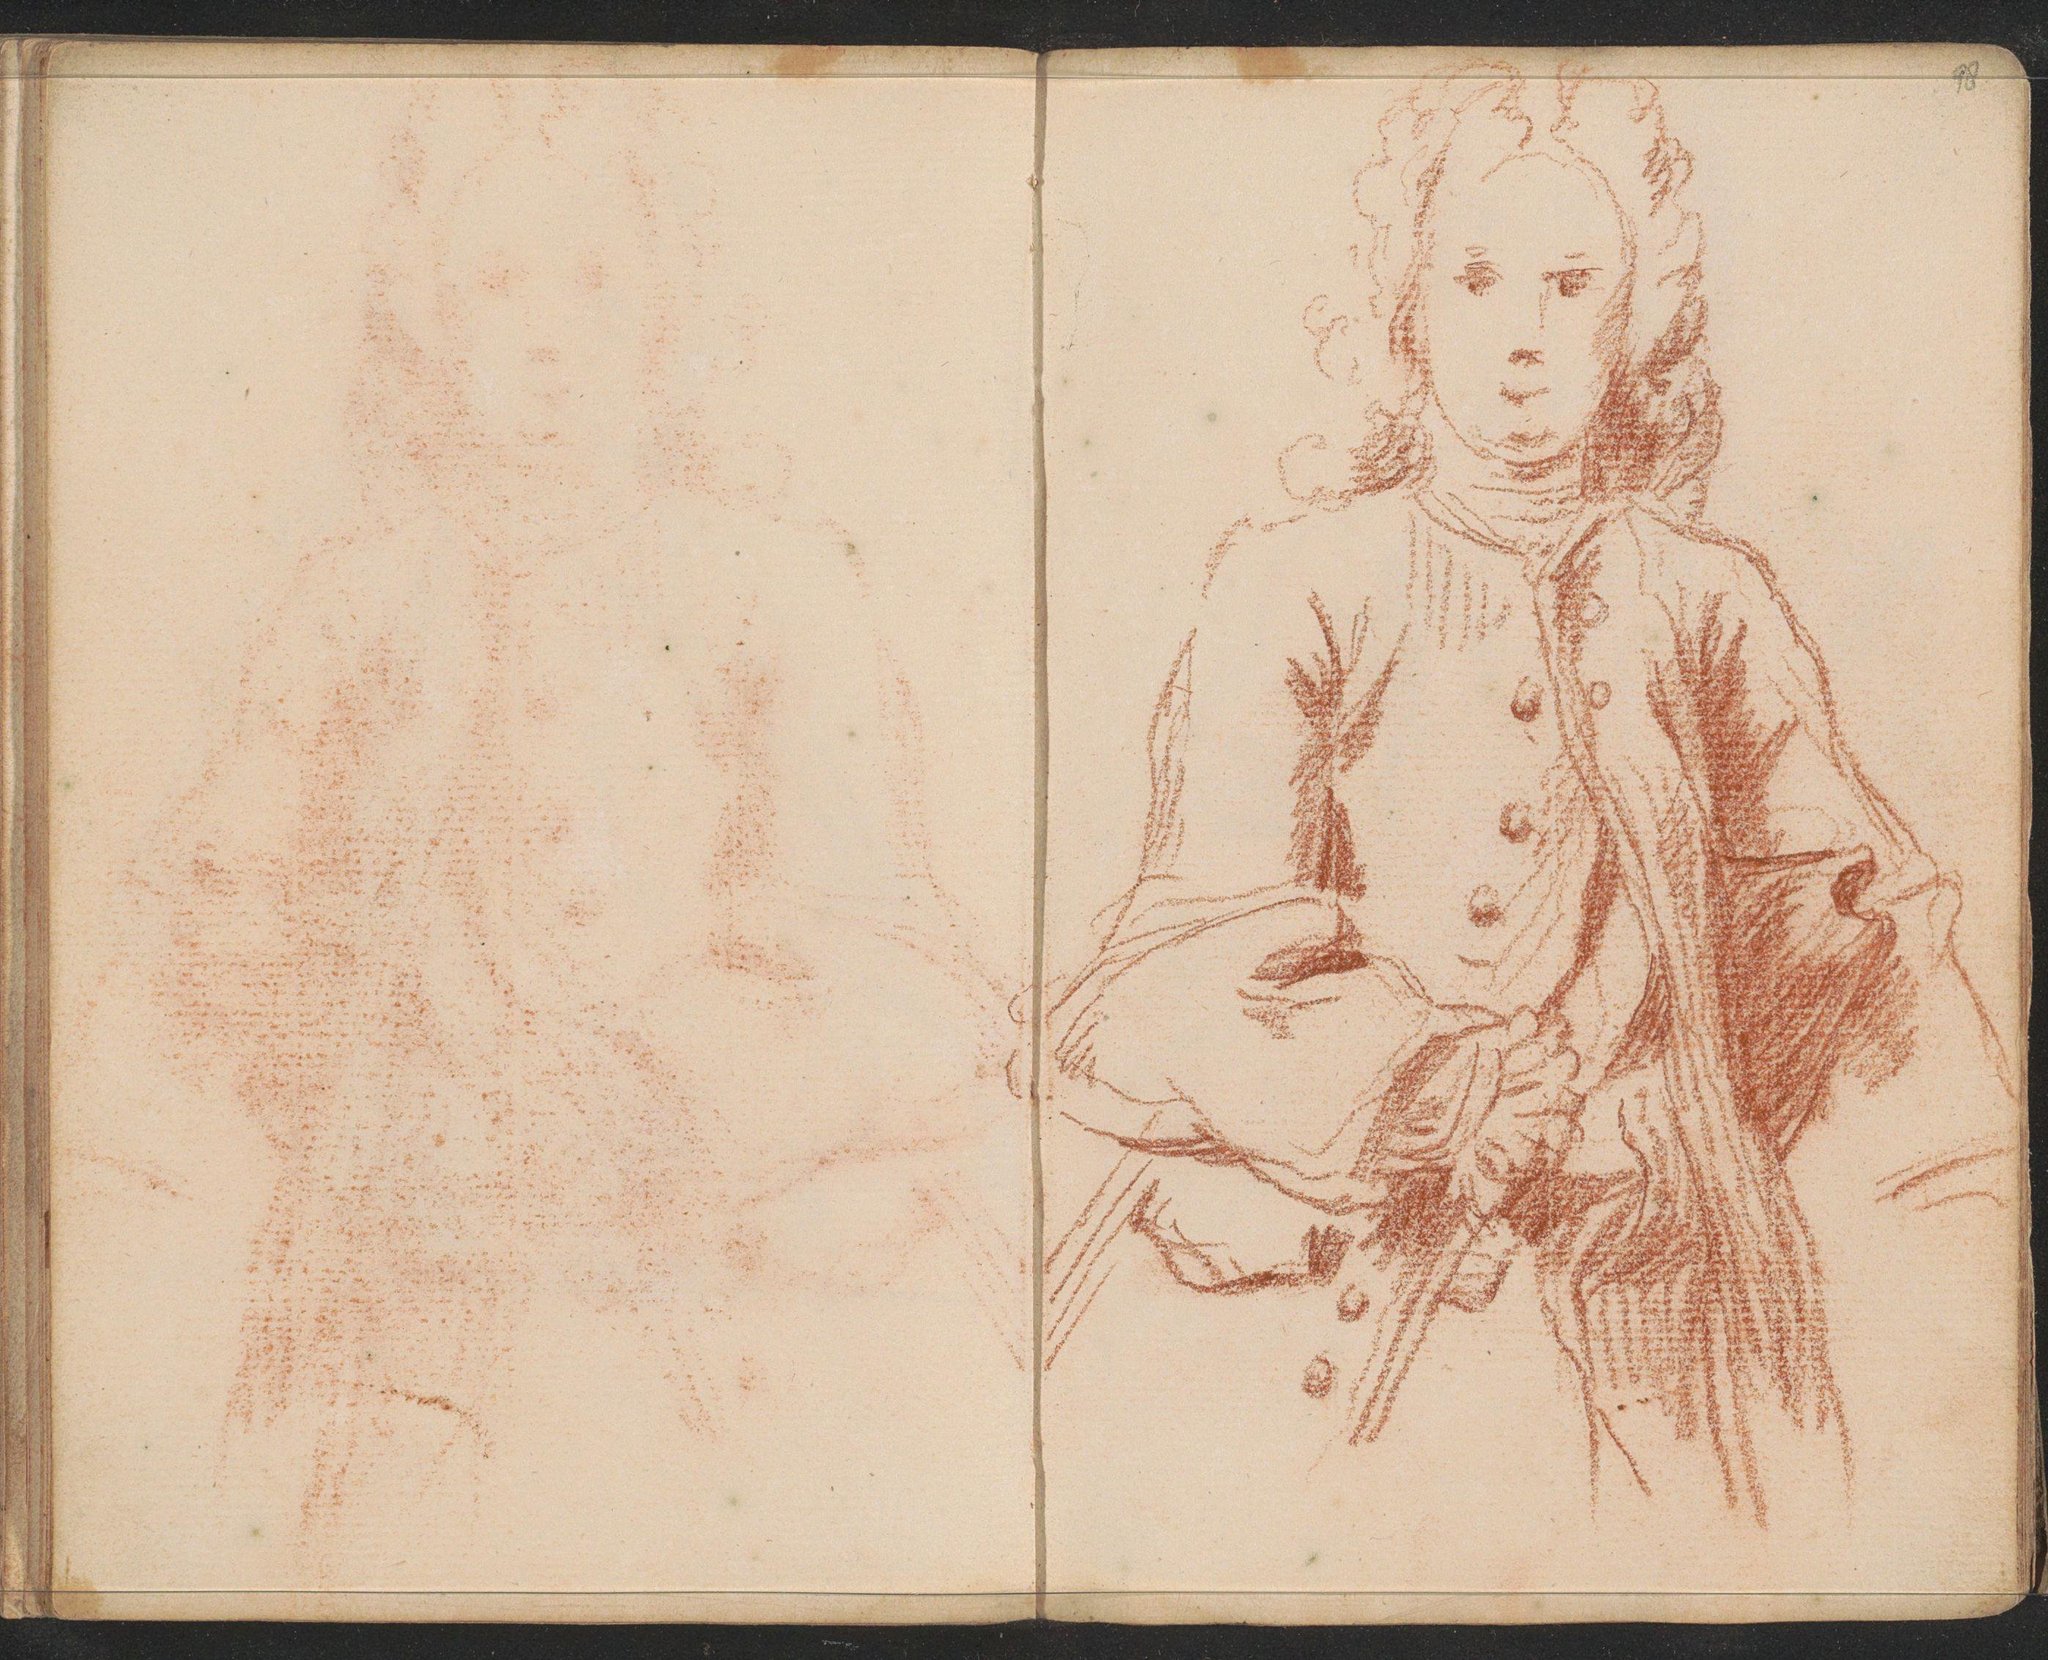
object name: sketchbook leaf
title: Staande man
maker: petrus johannes van reysschoot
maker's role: draughtsman, print maker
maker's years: 1702-1772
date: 1710-1772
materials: chalk, paper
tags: standing figure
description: Blad 97 verso en 98 recto uit een schetsboek met 105 bladen.